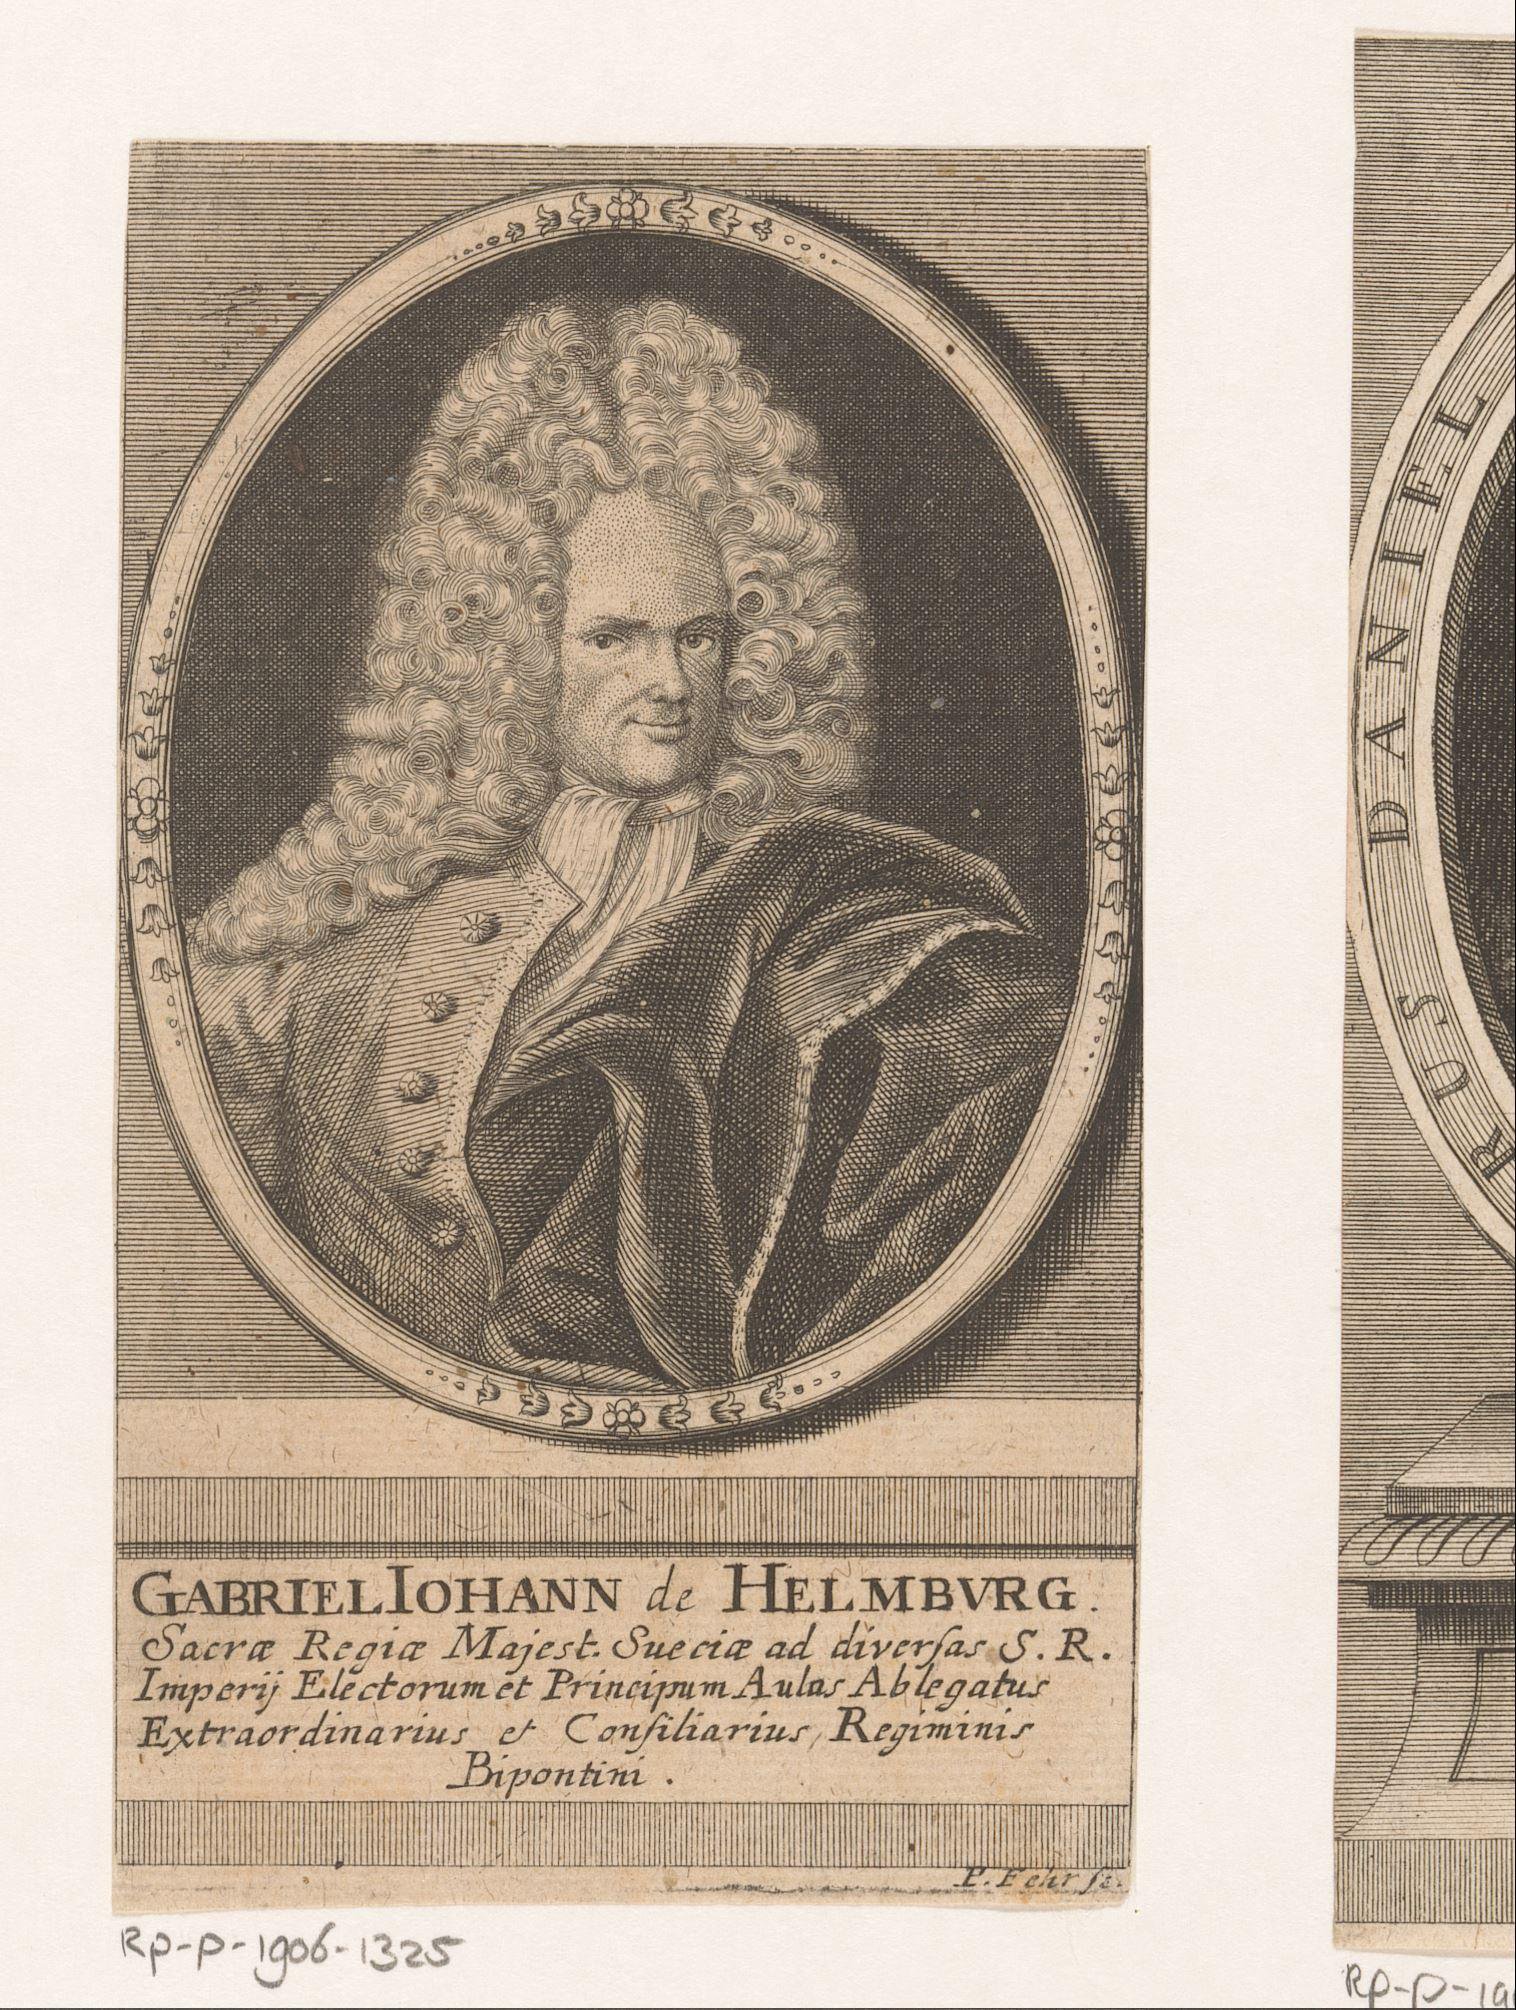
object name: print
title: Portret van Gabriel Johann de Helmburg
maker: peter fehr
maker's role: print maker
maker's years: 1681-1740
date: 1691-1740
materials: paper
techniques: engraving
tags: ornament ~ medallion, historical persons, wig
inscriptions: collector's mark: Lugt 2228